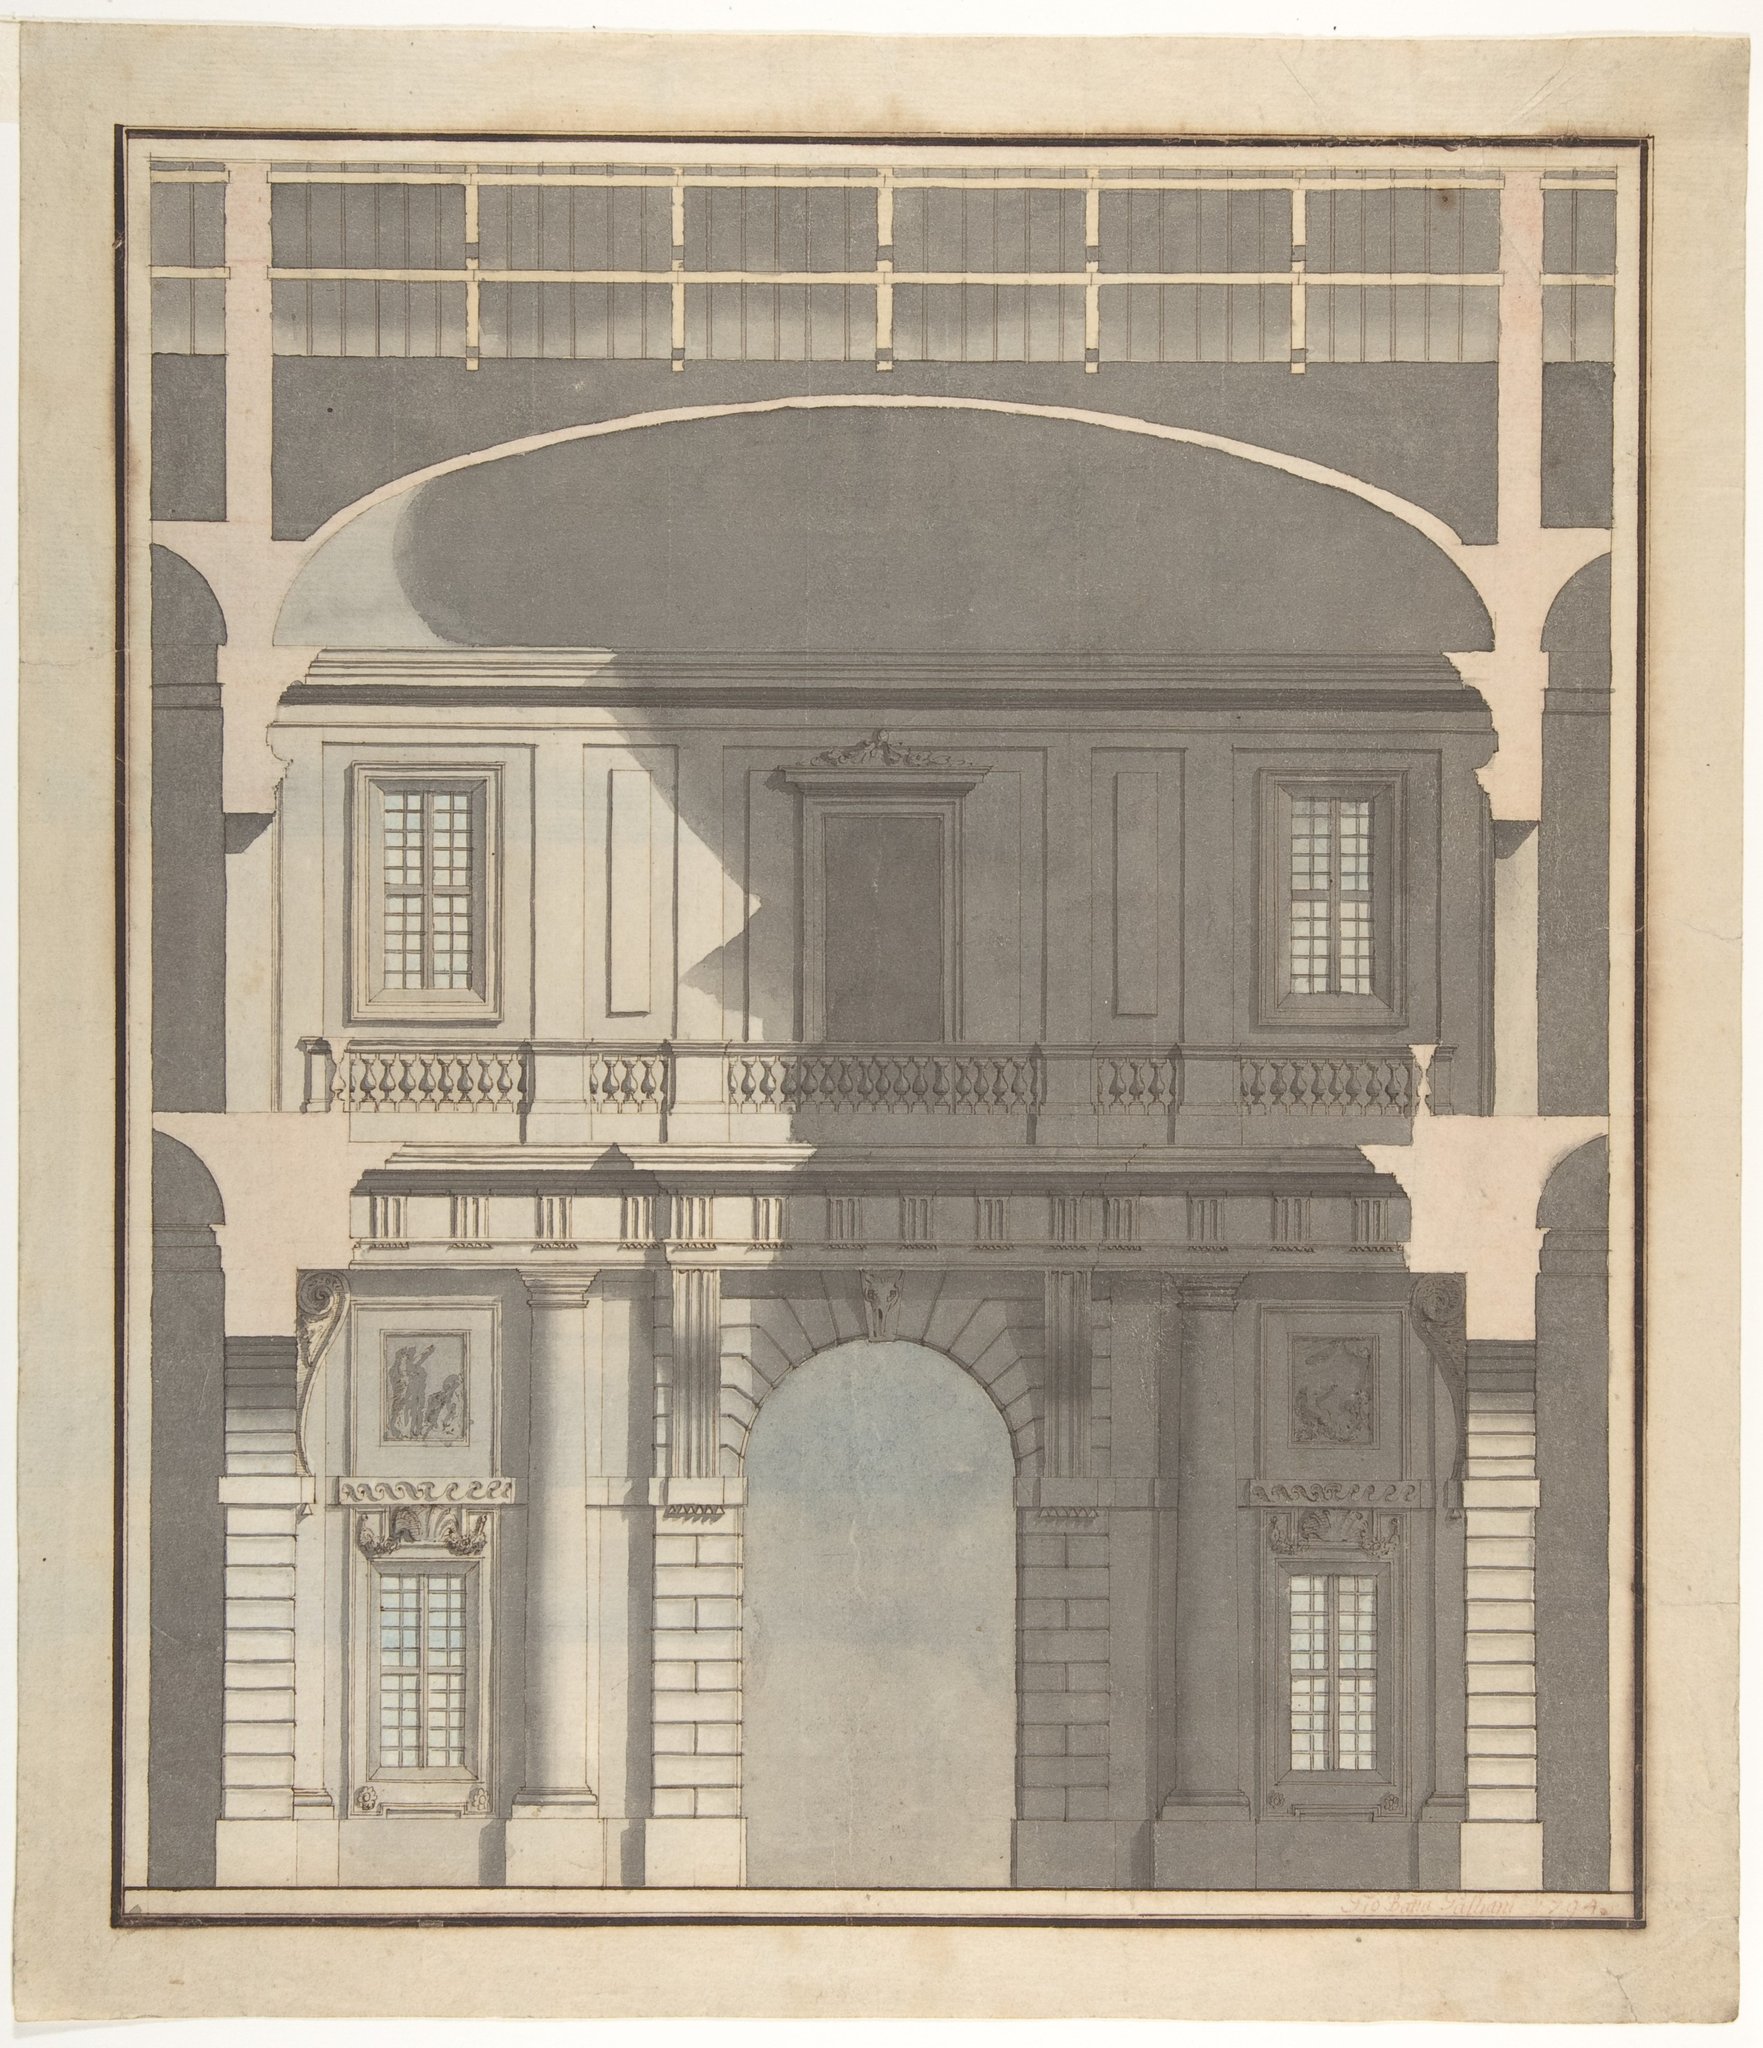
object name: drawing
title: Design for a Stage Set: Design in Section of a Two-Storied Entrance Hall (Recto). Elevation Design for a Monumental Entrance with Columns and Rounded Pediment (Verso).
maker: giovanni battista galliani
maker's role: artist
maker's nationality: italian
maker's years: 1794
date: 1794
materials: chalk, graphite, ink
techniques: brush, pen, wash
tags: stage design